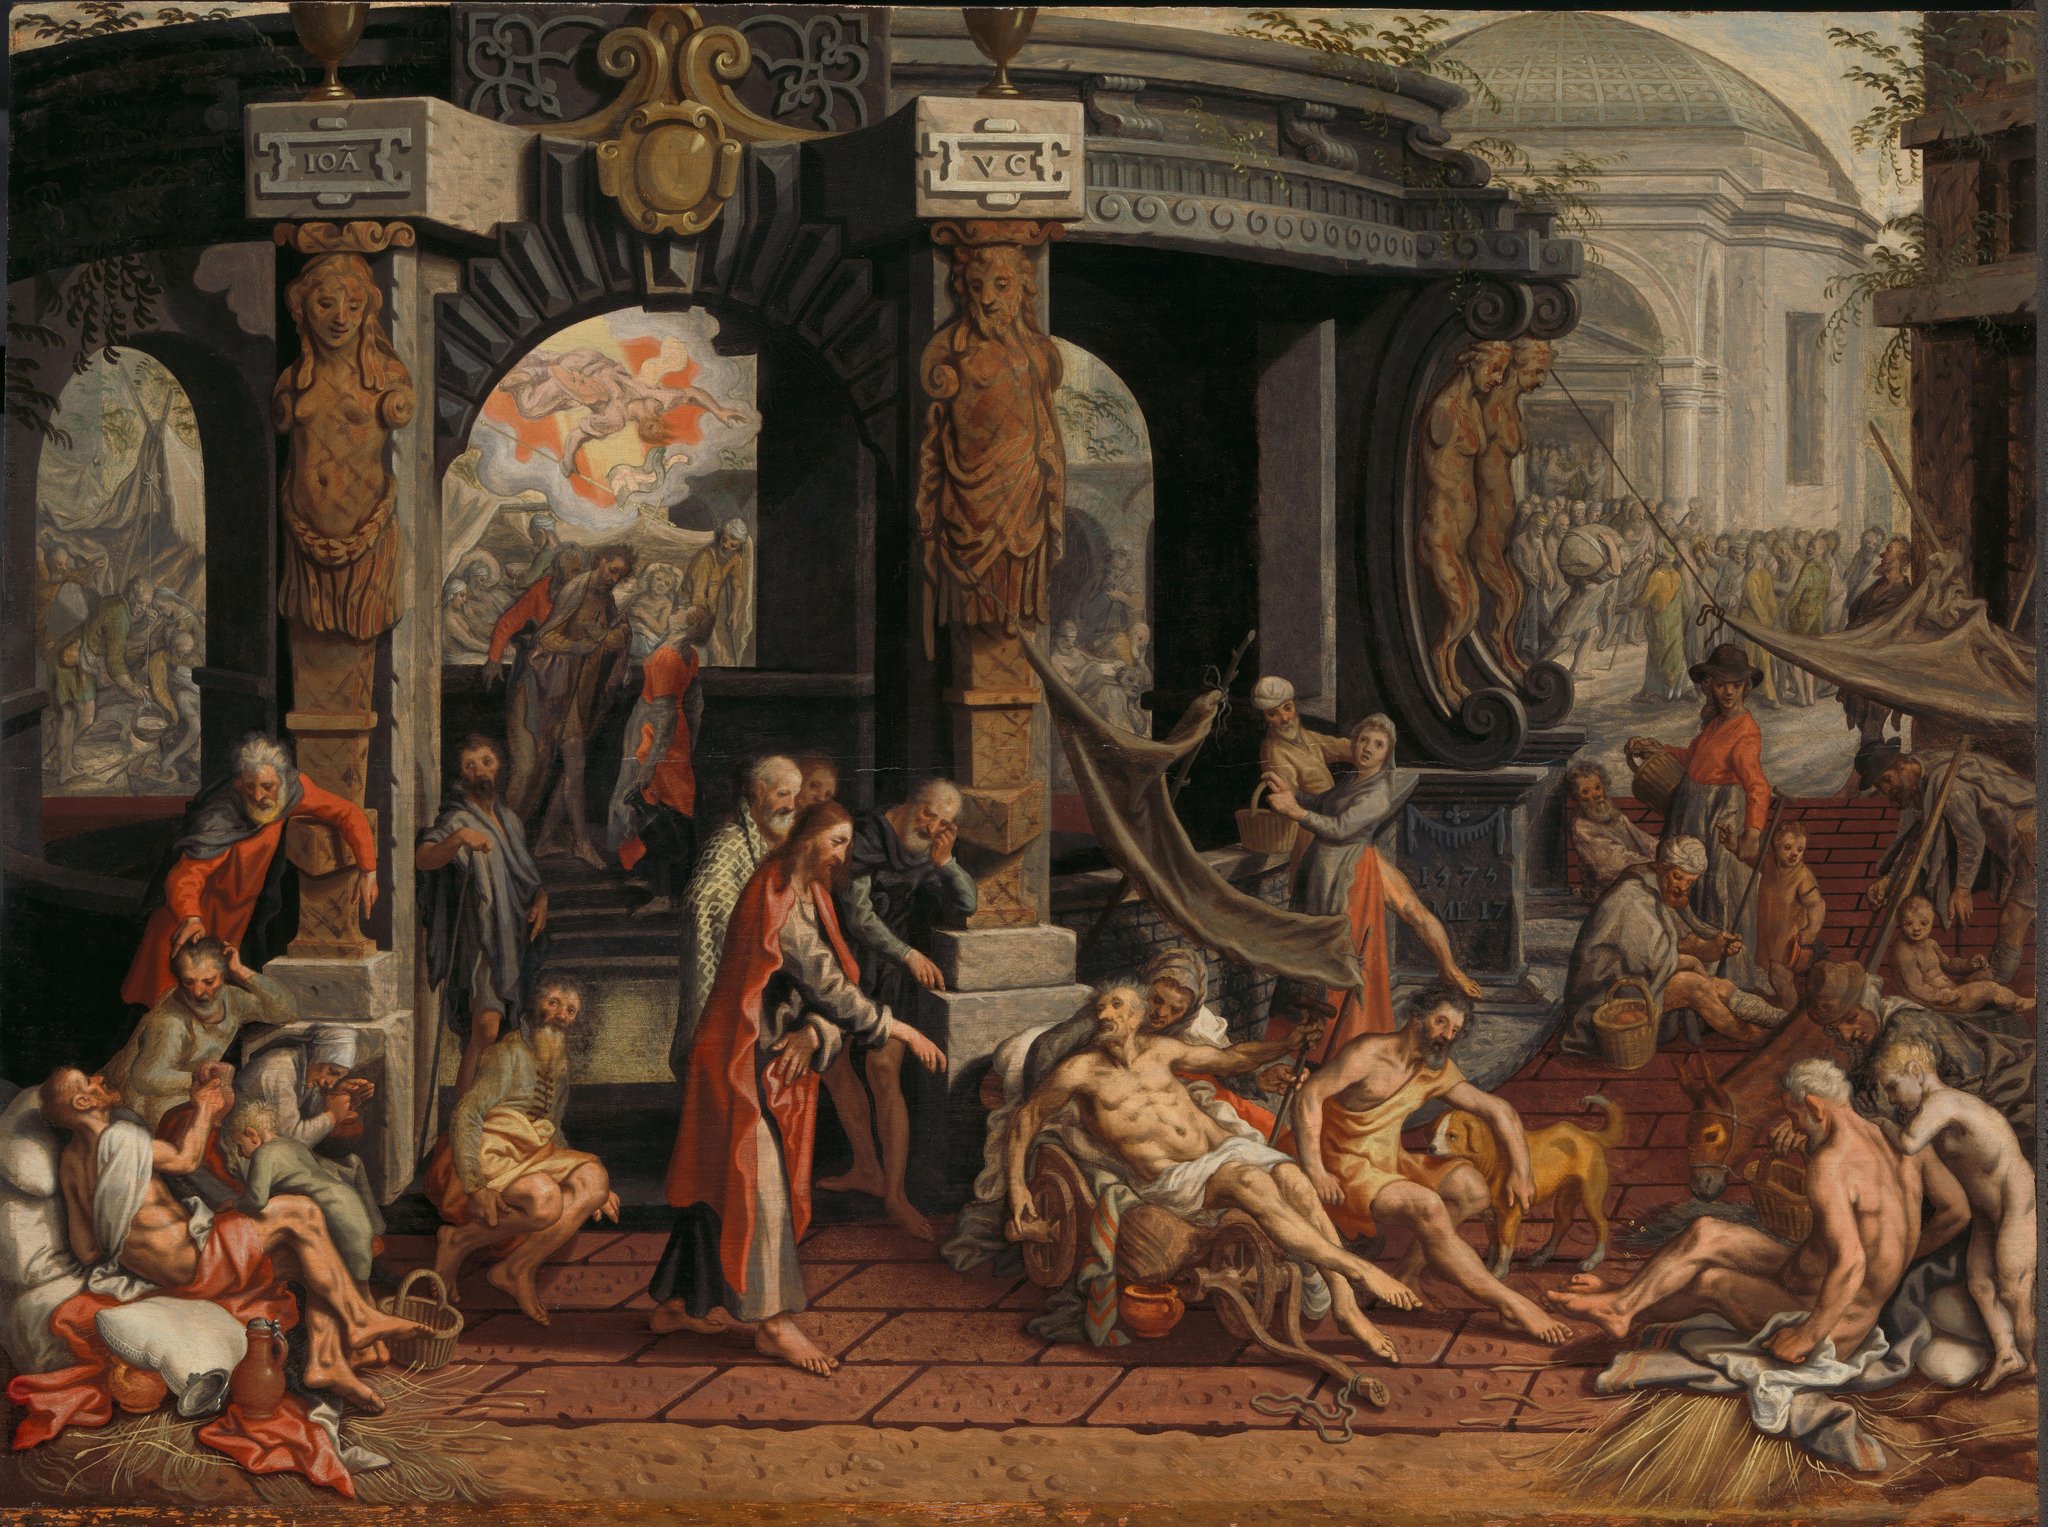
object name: painting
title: Healing of the paralized man at the pool of Bethesda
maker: pieter aertsen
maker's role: draughtsman, painter, print maker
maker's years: 1508-1575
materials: oil, panel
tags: sick people lying near the pool of bethesda ~ christ healing paralytics (john 5:1-9)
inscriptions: inscription: ‘Op de toegangspoort tot de bron: IOA VC (=Johannes 5, 1-16)’, signature and date: ‘Gemonogrammeerd en gedateerd: '1575/ME 17'’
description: De genezing van de verlamde man te Bethesda (Johannes 5:1-16). Christus staat voor een rijk gedecoreerde poort, waarvoor zich een groot aantal zieke mensen bevinden. Achter de poort is te zien hoe een engel in de genezende bron duikt.